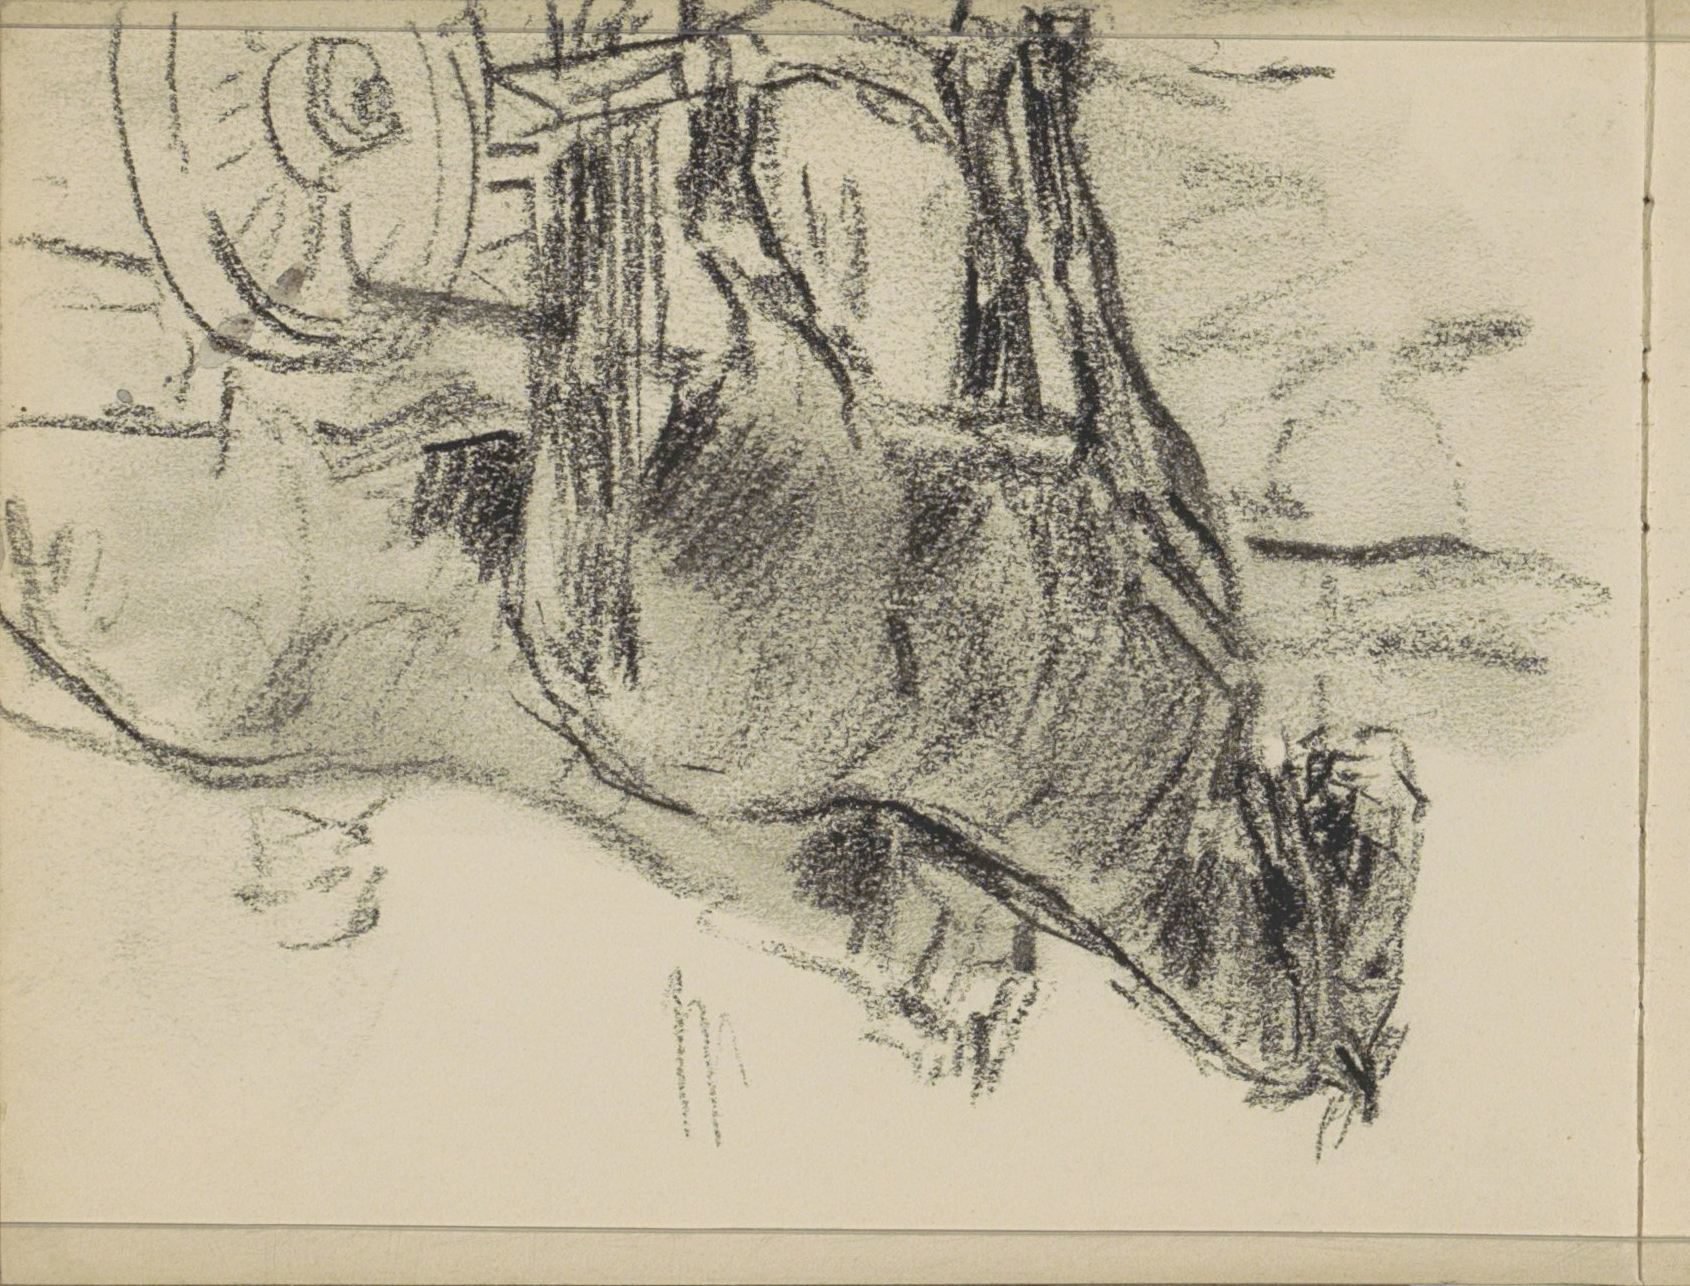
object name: sketchbook leaf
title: Twee aangespannen paarden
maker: johan antonie de jonge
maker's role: draughtsman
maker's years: 1864-1927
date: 1881-1927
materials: chalk, paper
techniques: stumping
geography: south holland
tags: adult man, horse, agricultural implements: plough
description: Twee paarden voor een kar of ploeg. Naast hen een figuur. Blad 32 verso uit een schetsboek met 34 bladen.